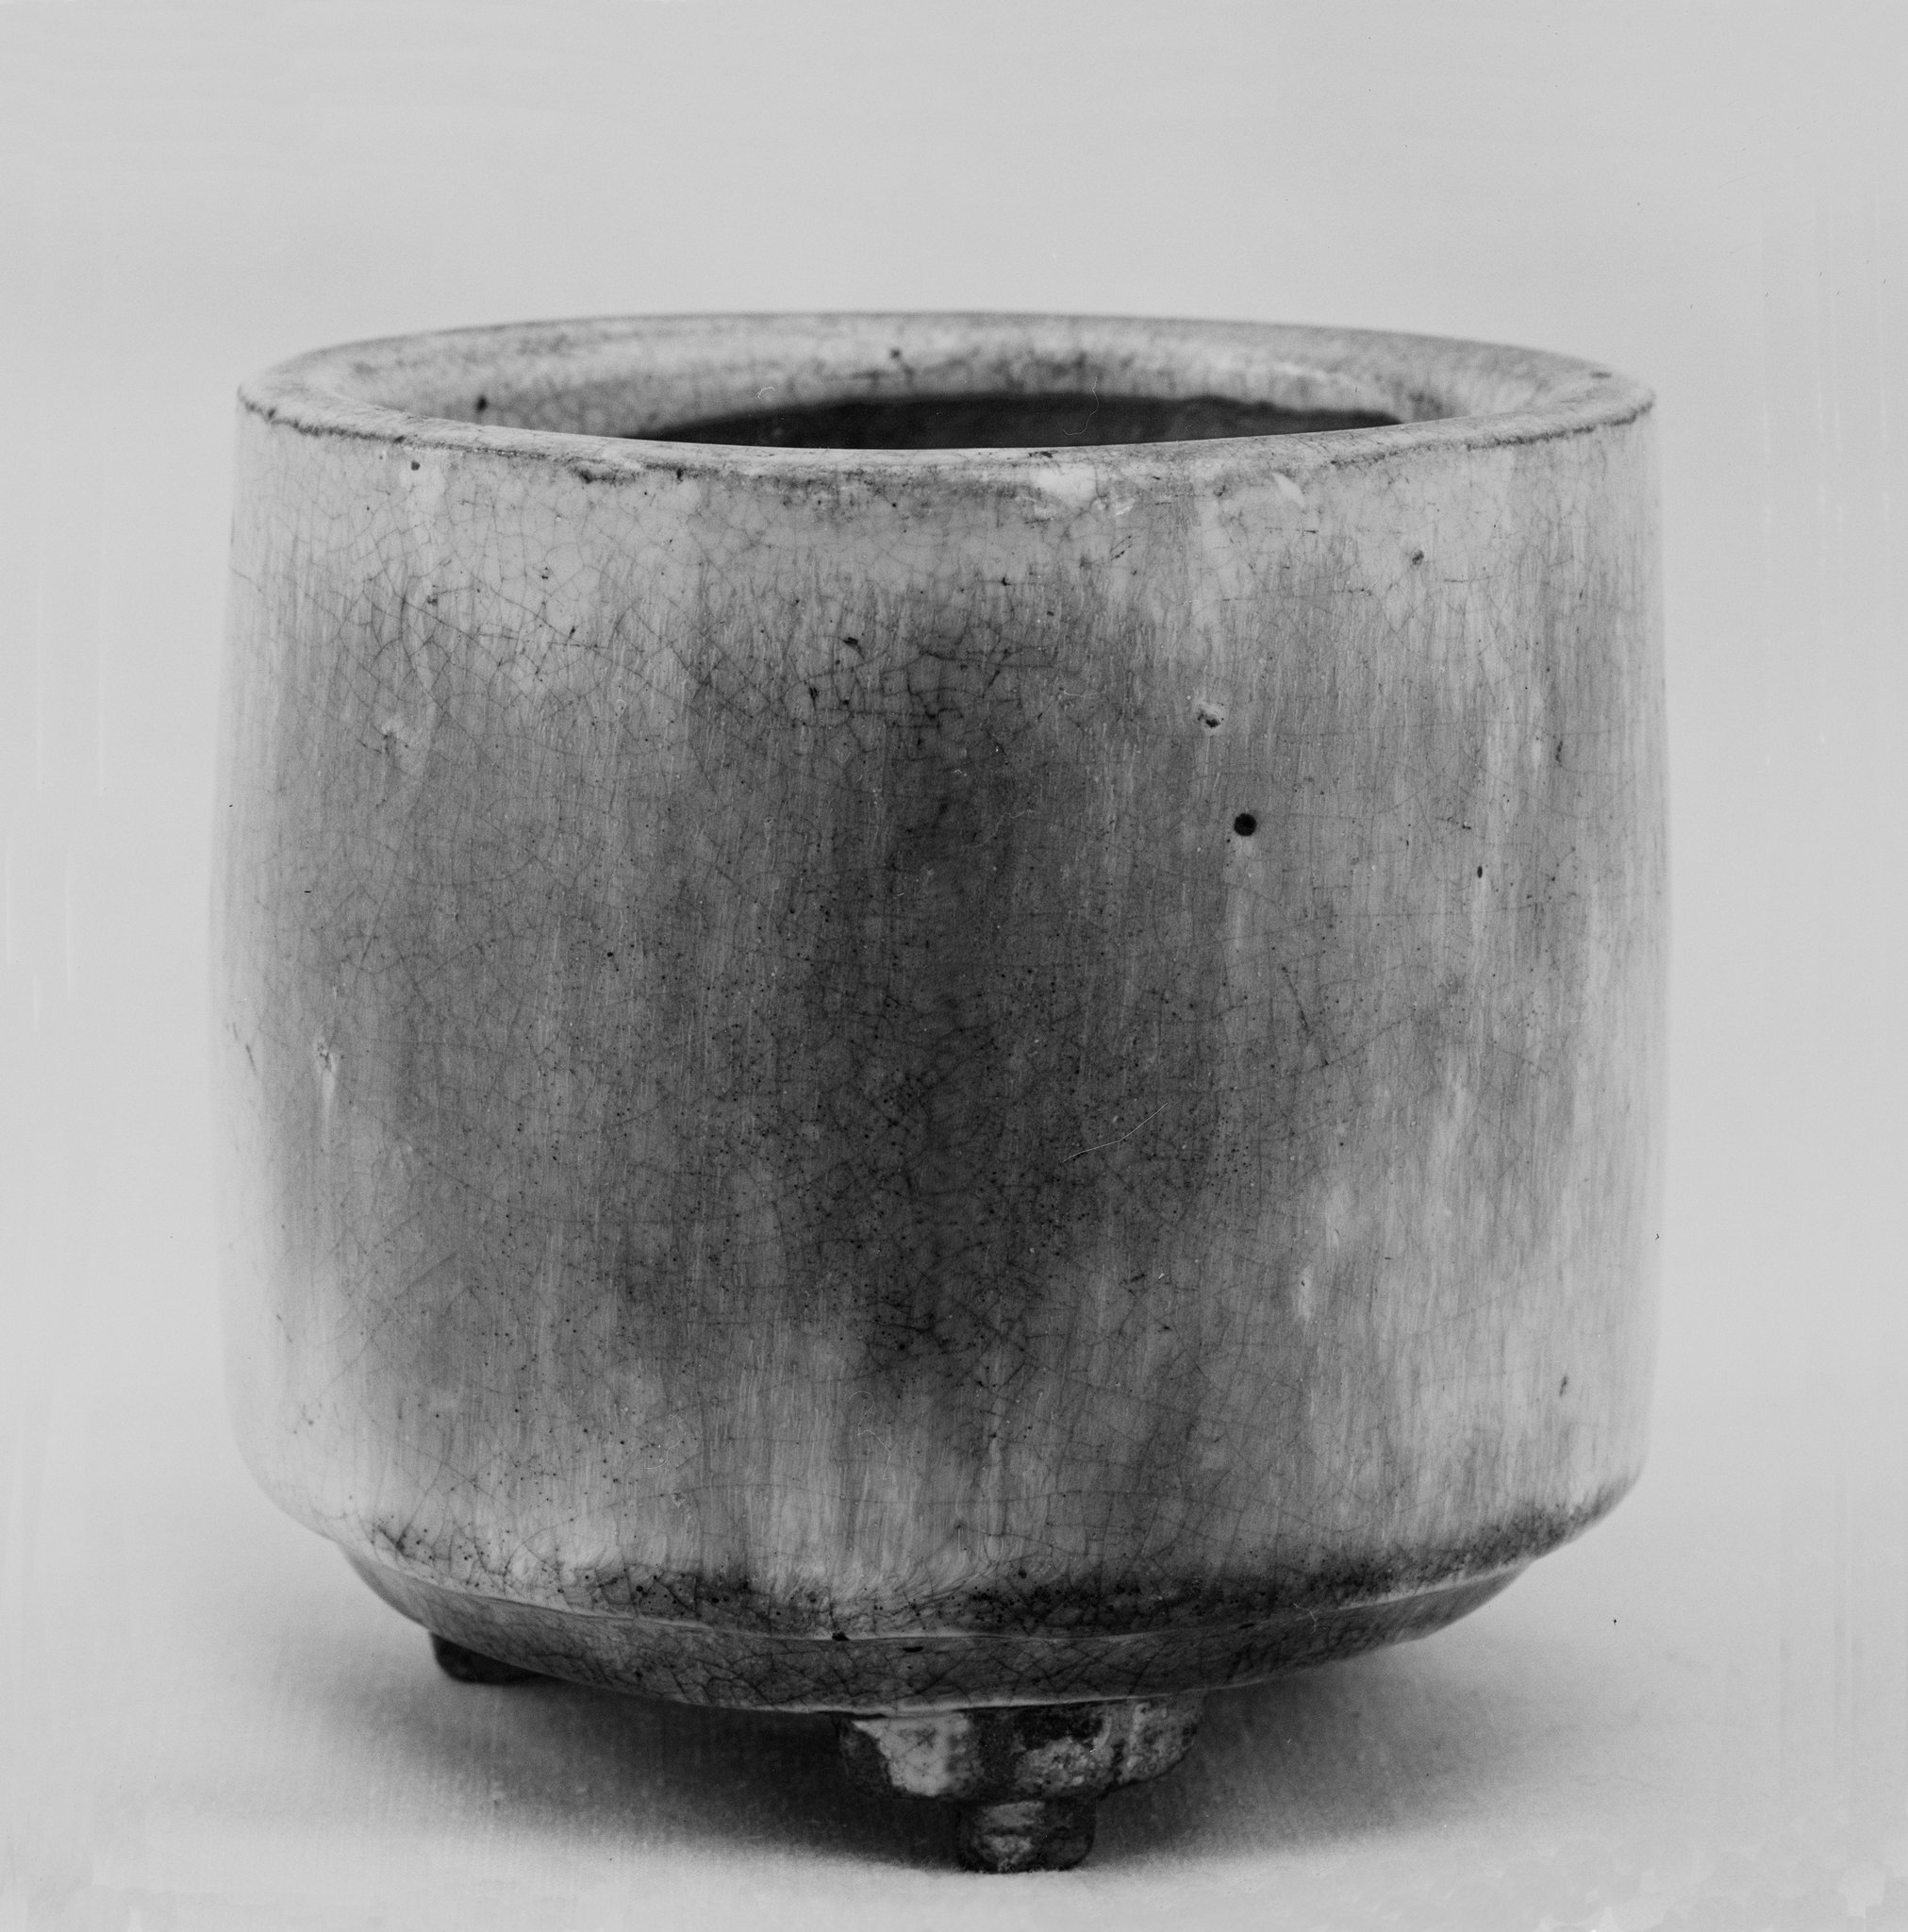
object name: fire bowl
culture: japanese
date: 1801-1900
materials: clay, glaze